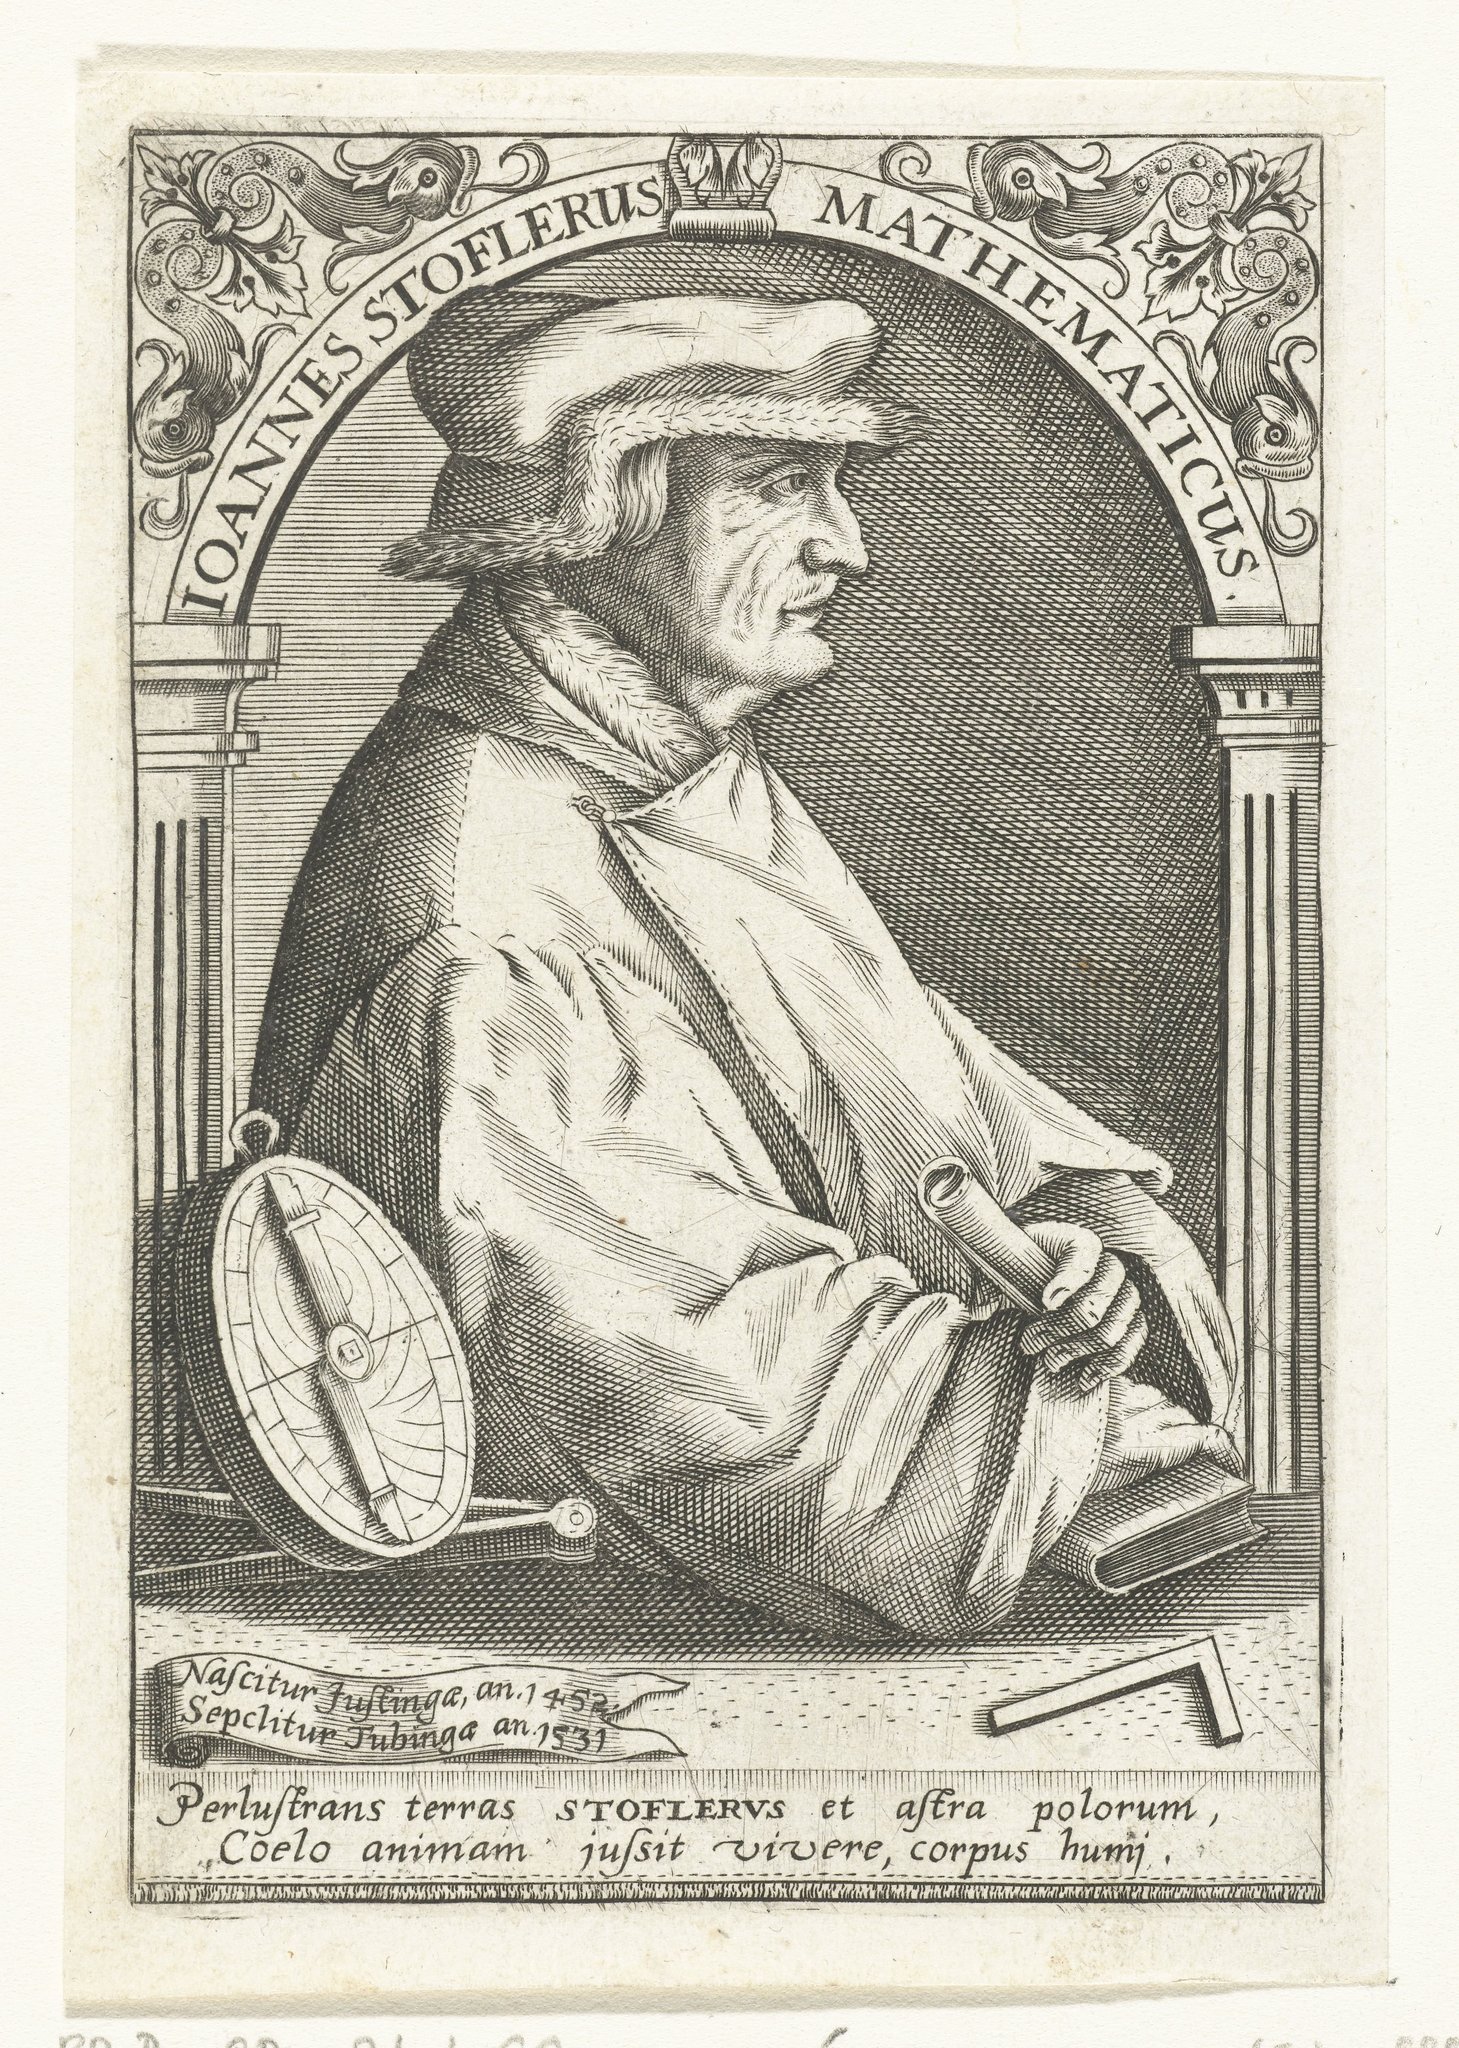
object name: book illustration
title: Ioannes Stoflerus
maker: jean jacques boissard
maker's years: 1528-1598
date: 1597-1599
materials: paper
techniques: engraving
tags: publisher, johannes stöffler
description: Gemaakt voor: J.J. Boissard, Icones virorum illustrium doctrina &c eruditione praestanti um contines. Frankfurt am Main: de Bry, 1597-1599.